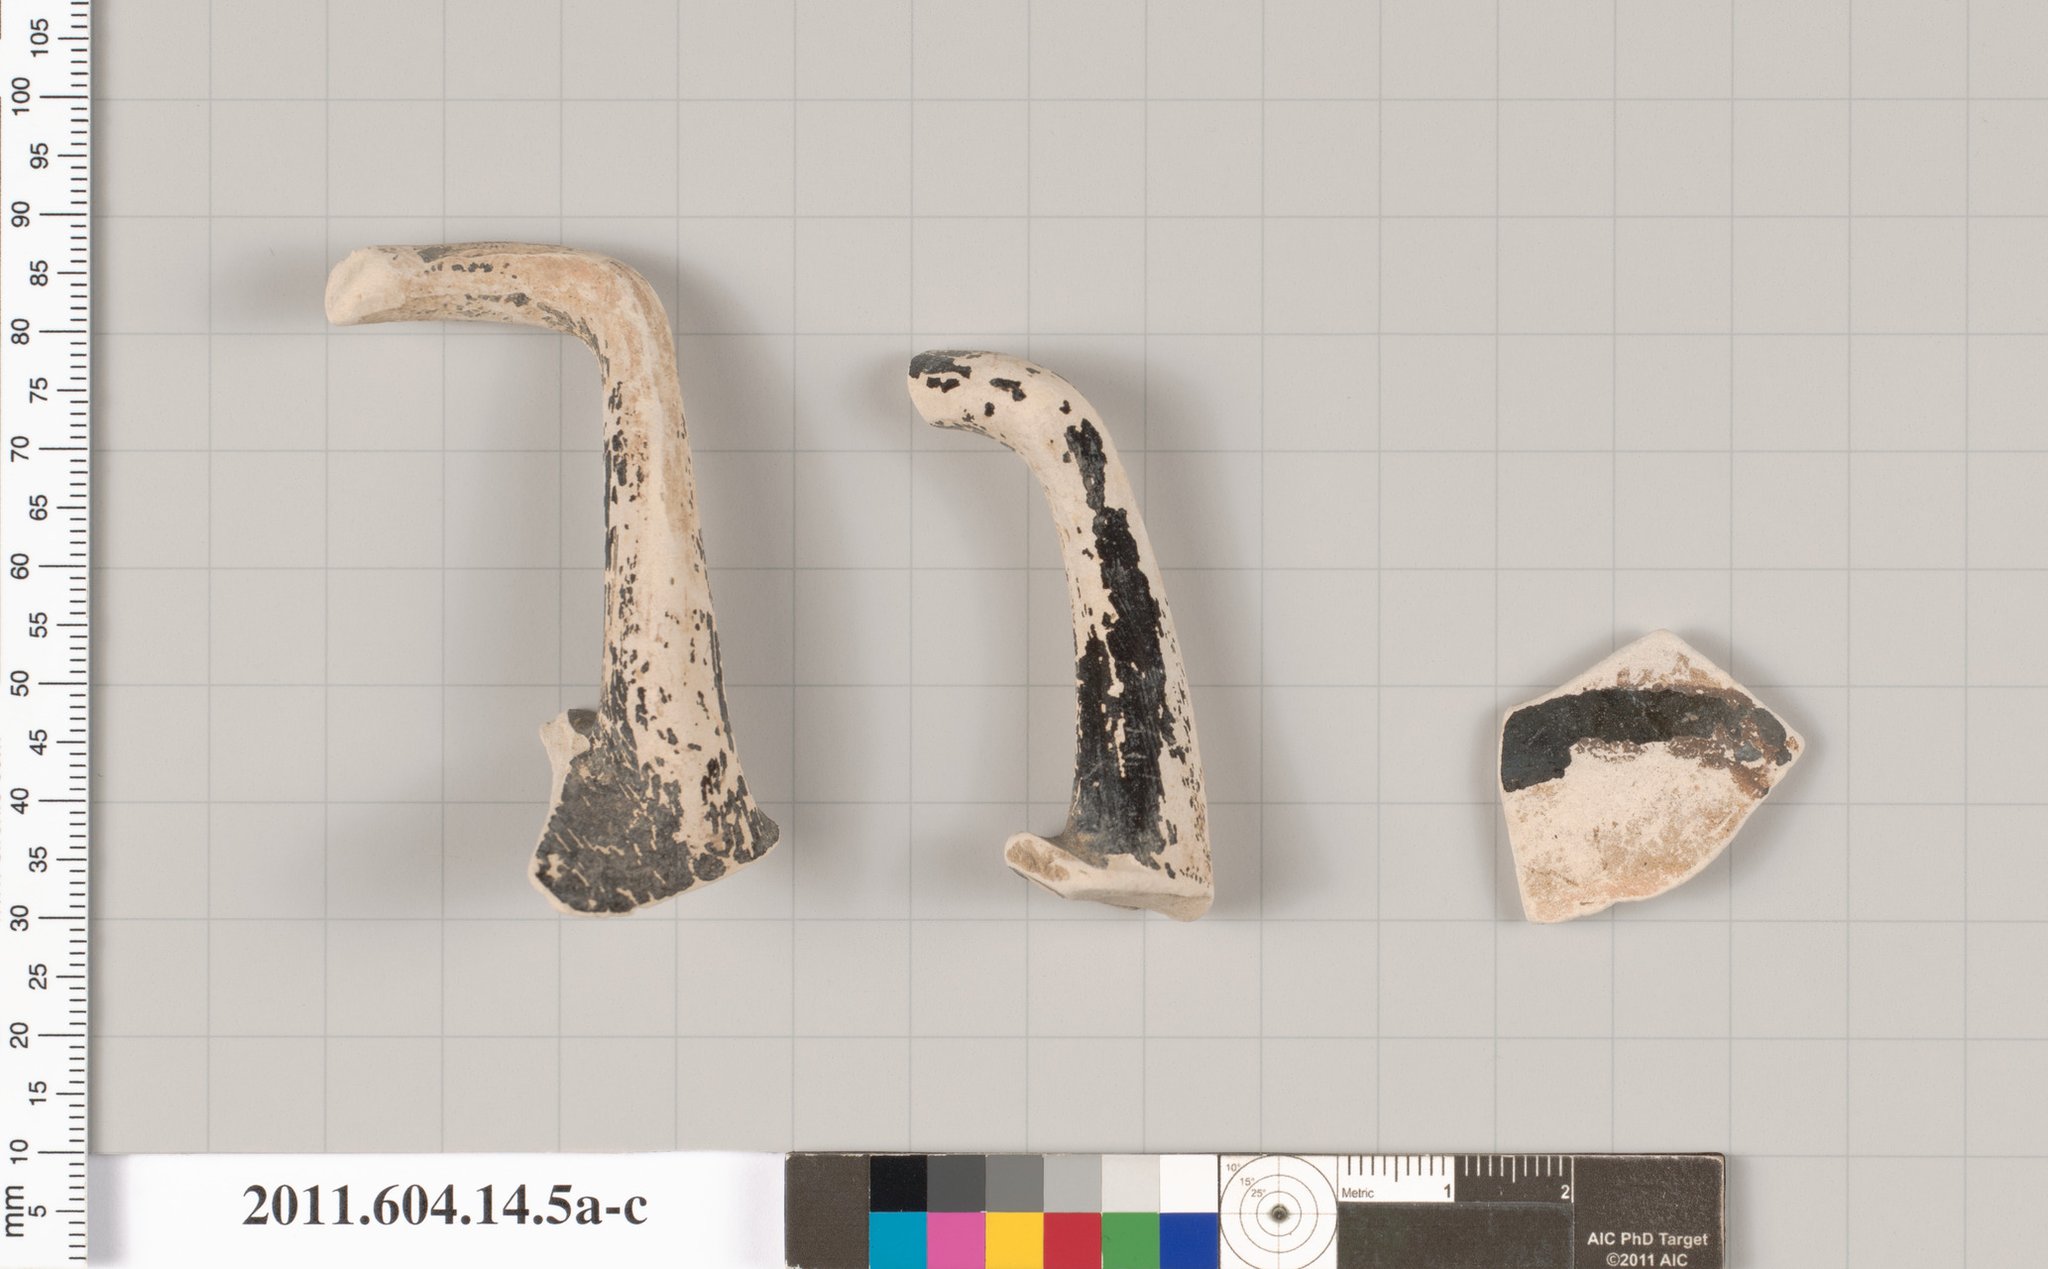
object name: kylix fragment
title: Terracotta fragments of a kylix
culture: unknown fabric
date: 600-501 BCE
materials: terracotta